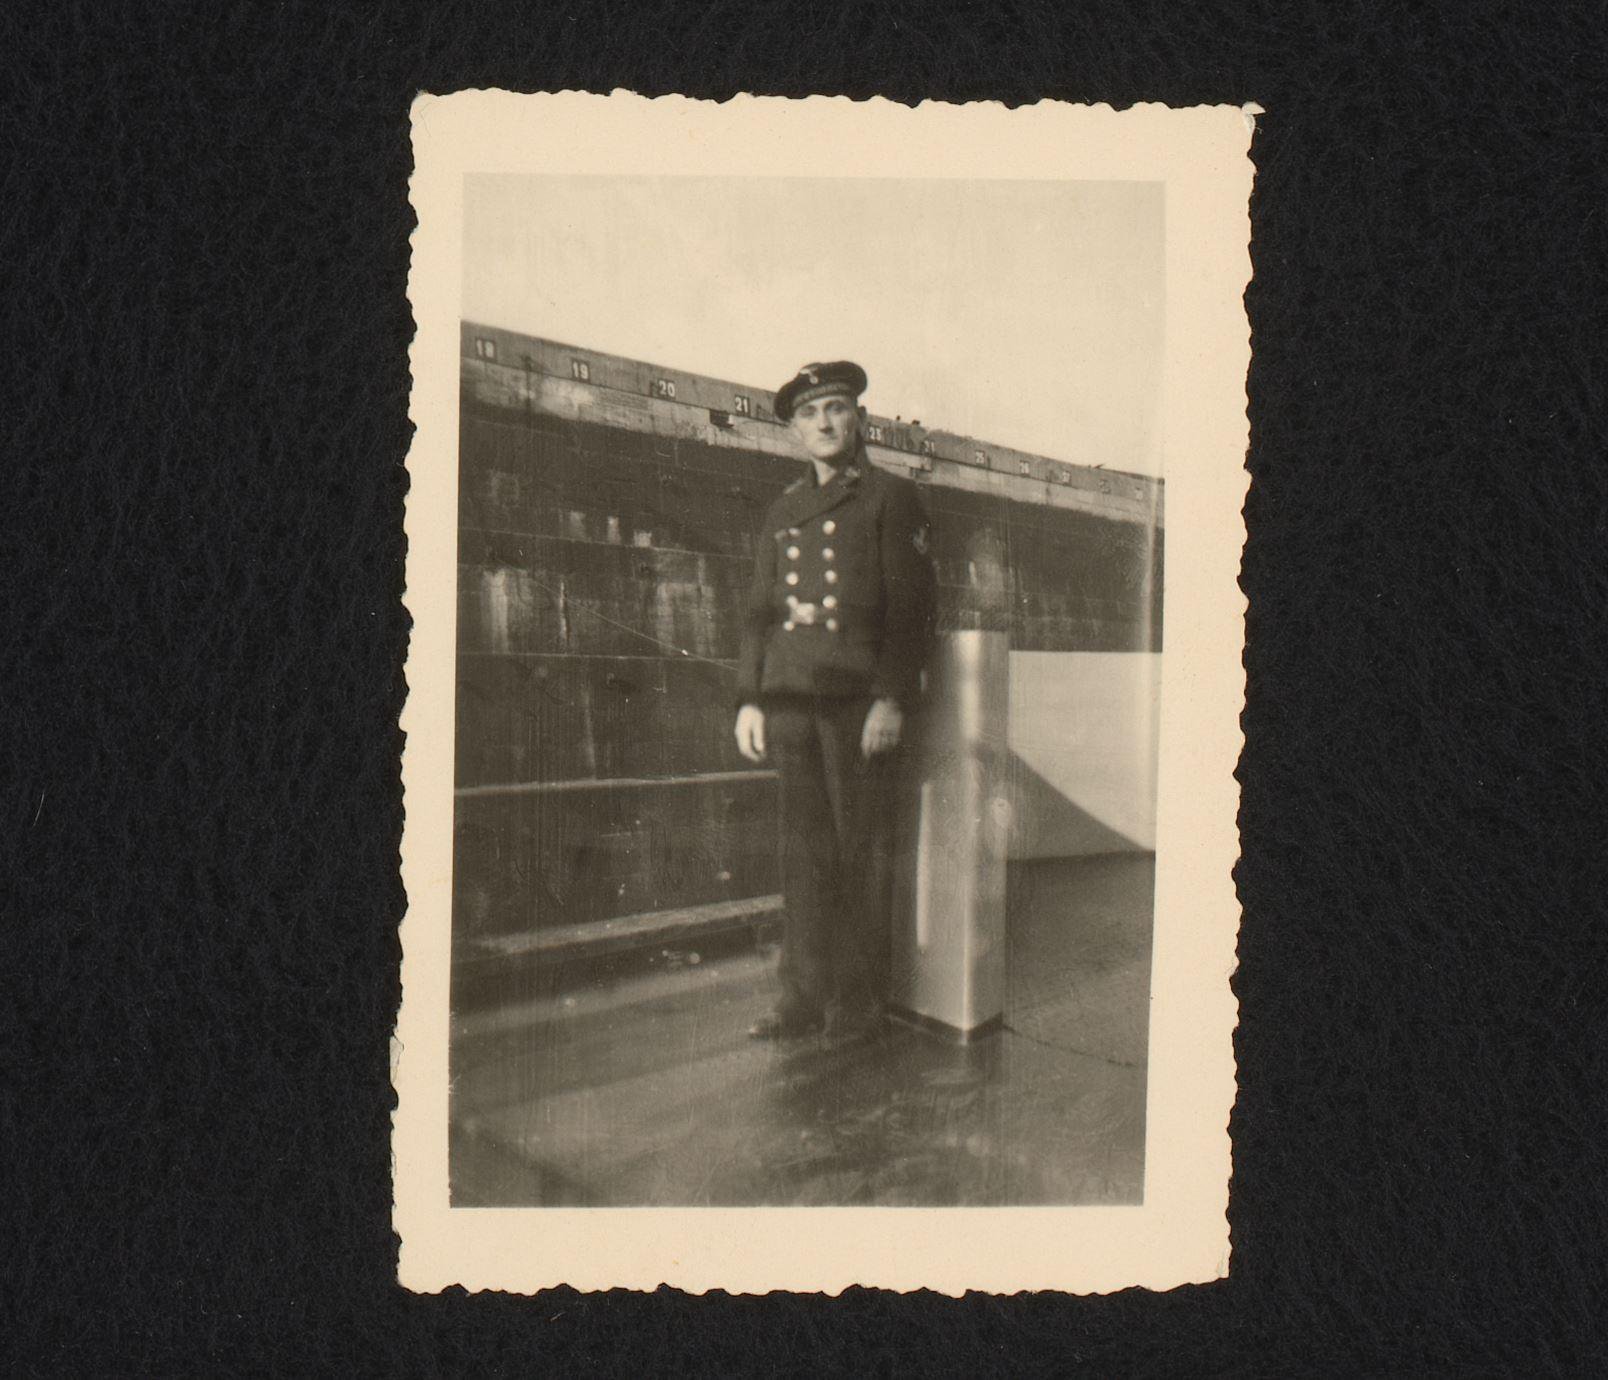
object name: photograph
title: Werner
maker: Anonymous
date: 1901-1944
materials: paper, photographic support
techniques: gelatin silver print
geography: la spezia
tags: werner neufang, sailor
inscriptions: inscription: ‘im Dock / La Spezia / Januar 1944.’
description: Werner, in de haven van La Spezia, januari 1944. Onderdeel van de groep losse foto's behorend bij het fotoalbum over de Duitse Werner Neufang van de Kriegsmarine en de Nederlandse Thea Driesen.